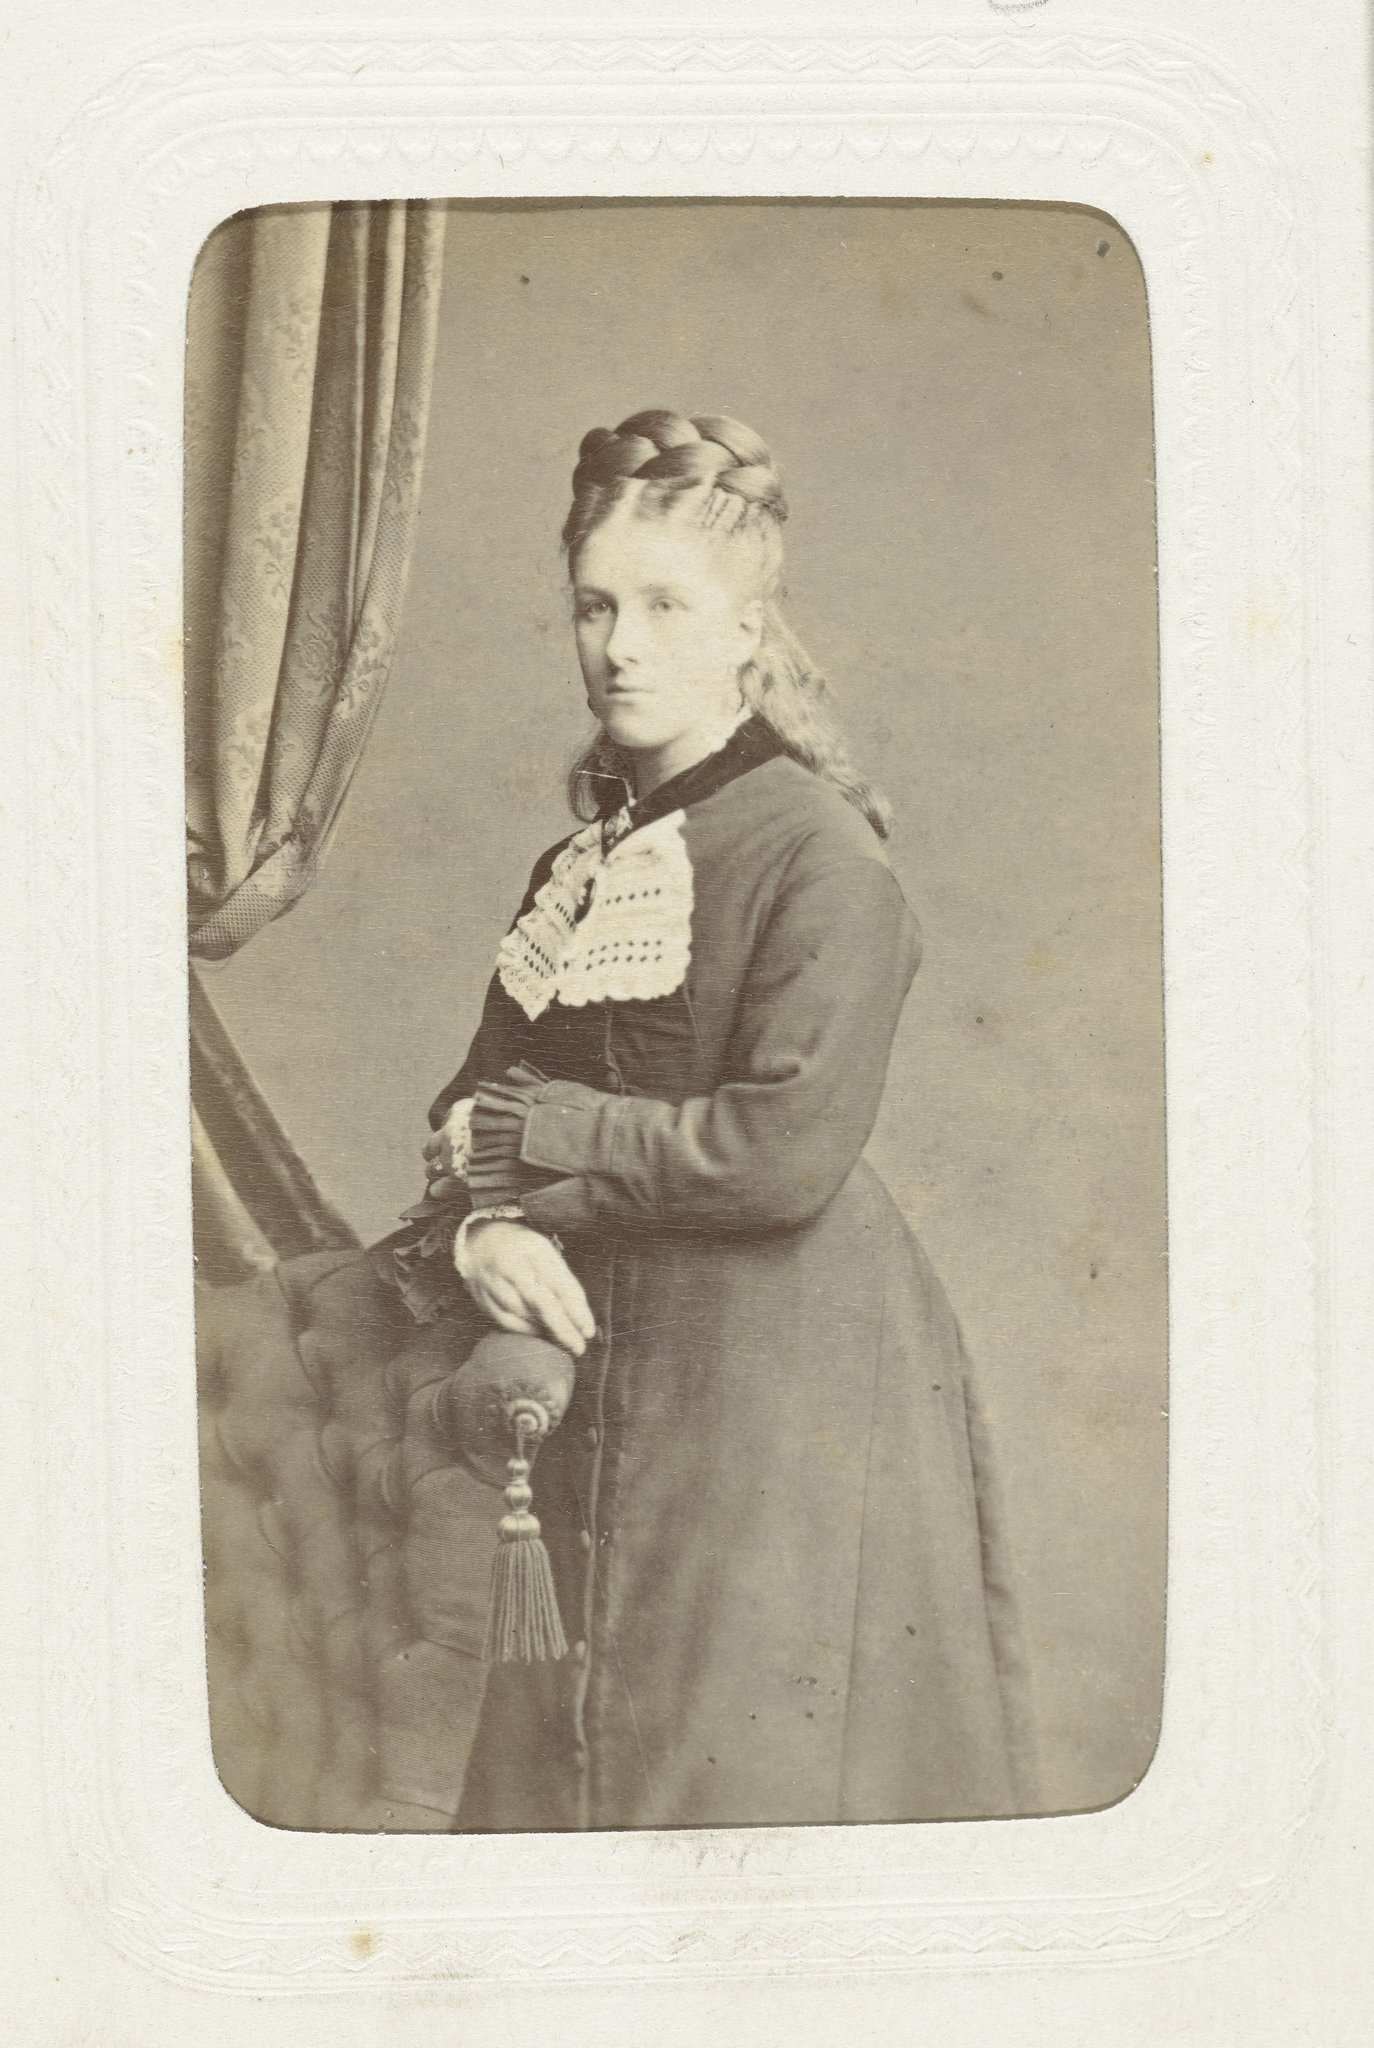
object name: carte de visite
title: Studioportret van een vrouw met een grote vlecht rond haar hoofd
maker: albert greiner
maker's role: fotograaf, fotostudio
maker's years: 1833-1890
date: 1863-1866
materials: cardboard, paper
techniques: albumen print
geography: amsterdam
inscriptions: name: ‘A. Diepenbach, Kleef’